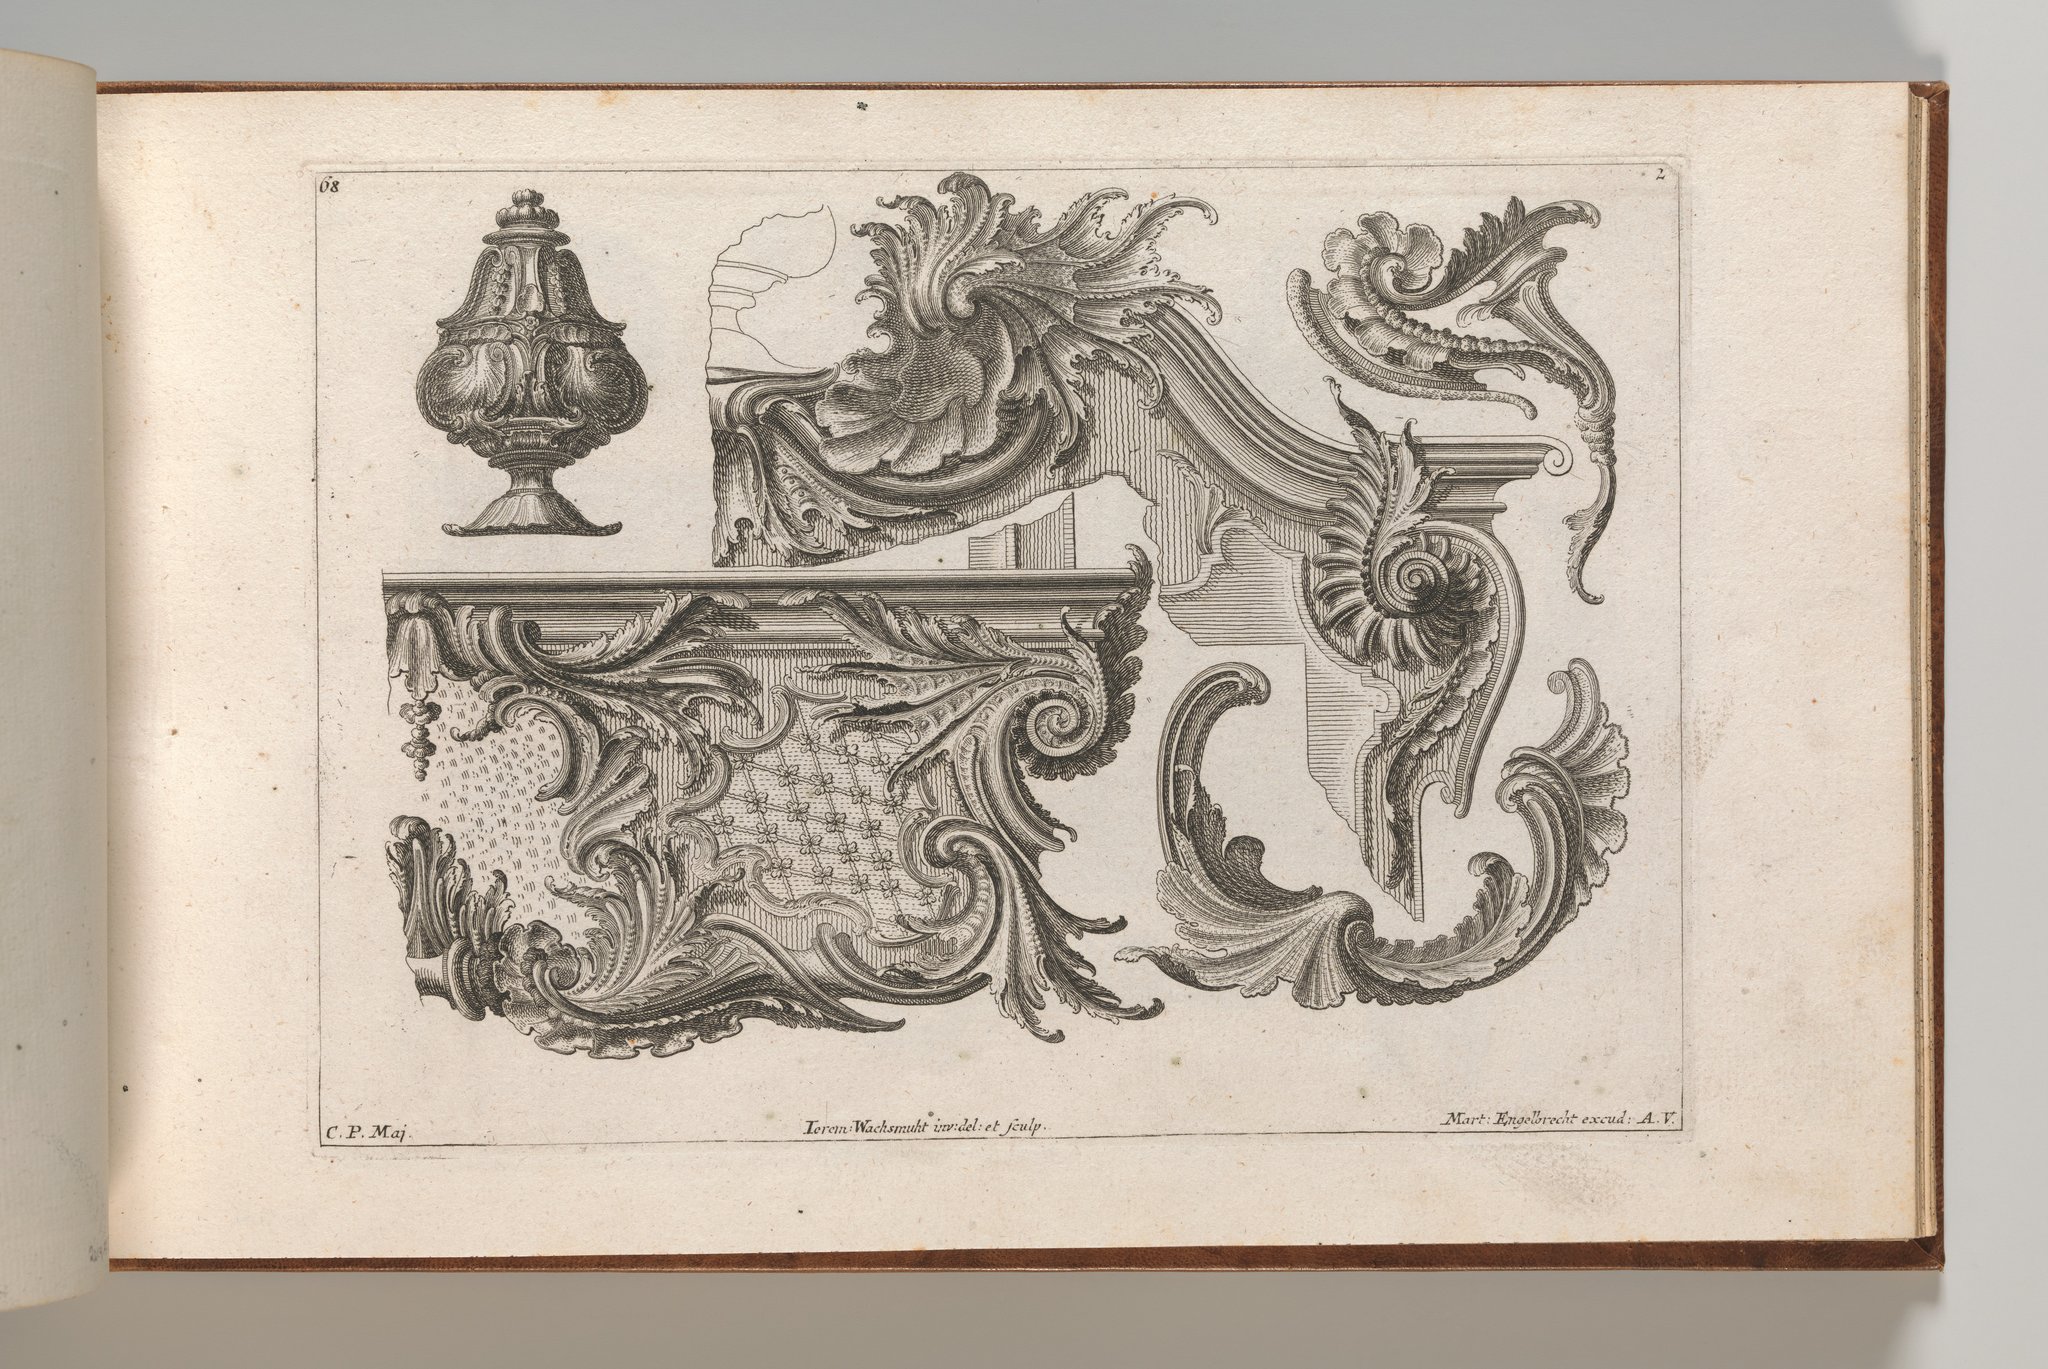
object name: album print ornament architecture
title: Suggestion for the Decoration of the Lower and Top Right of a Frame Combined with Several Additional Ornaments, Plate 2 from: 'Unterschidliche Auszierungen zu Thüren und Fenster, etc. etc. sehr nutzlich zu gebrauchen'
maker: jeremias wachsmuth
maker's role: artist and engraver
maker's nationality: german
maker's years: 1712-1771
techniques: etching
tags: ornament